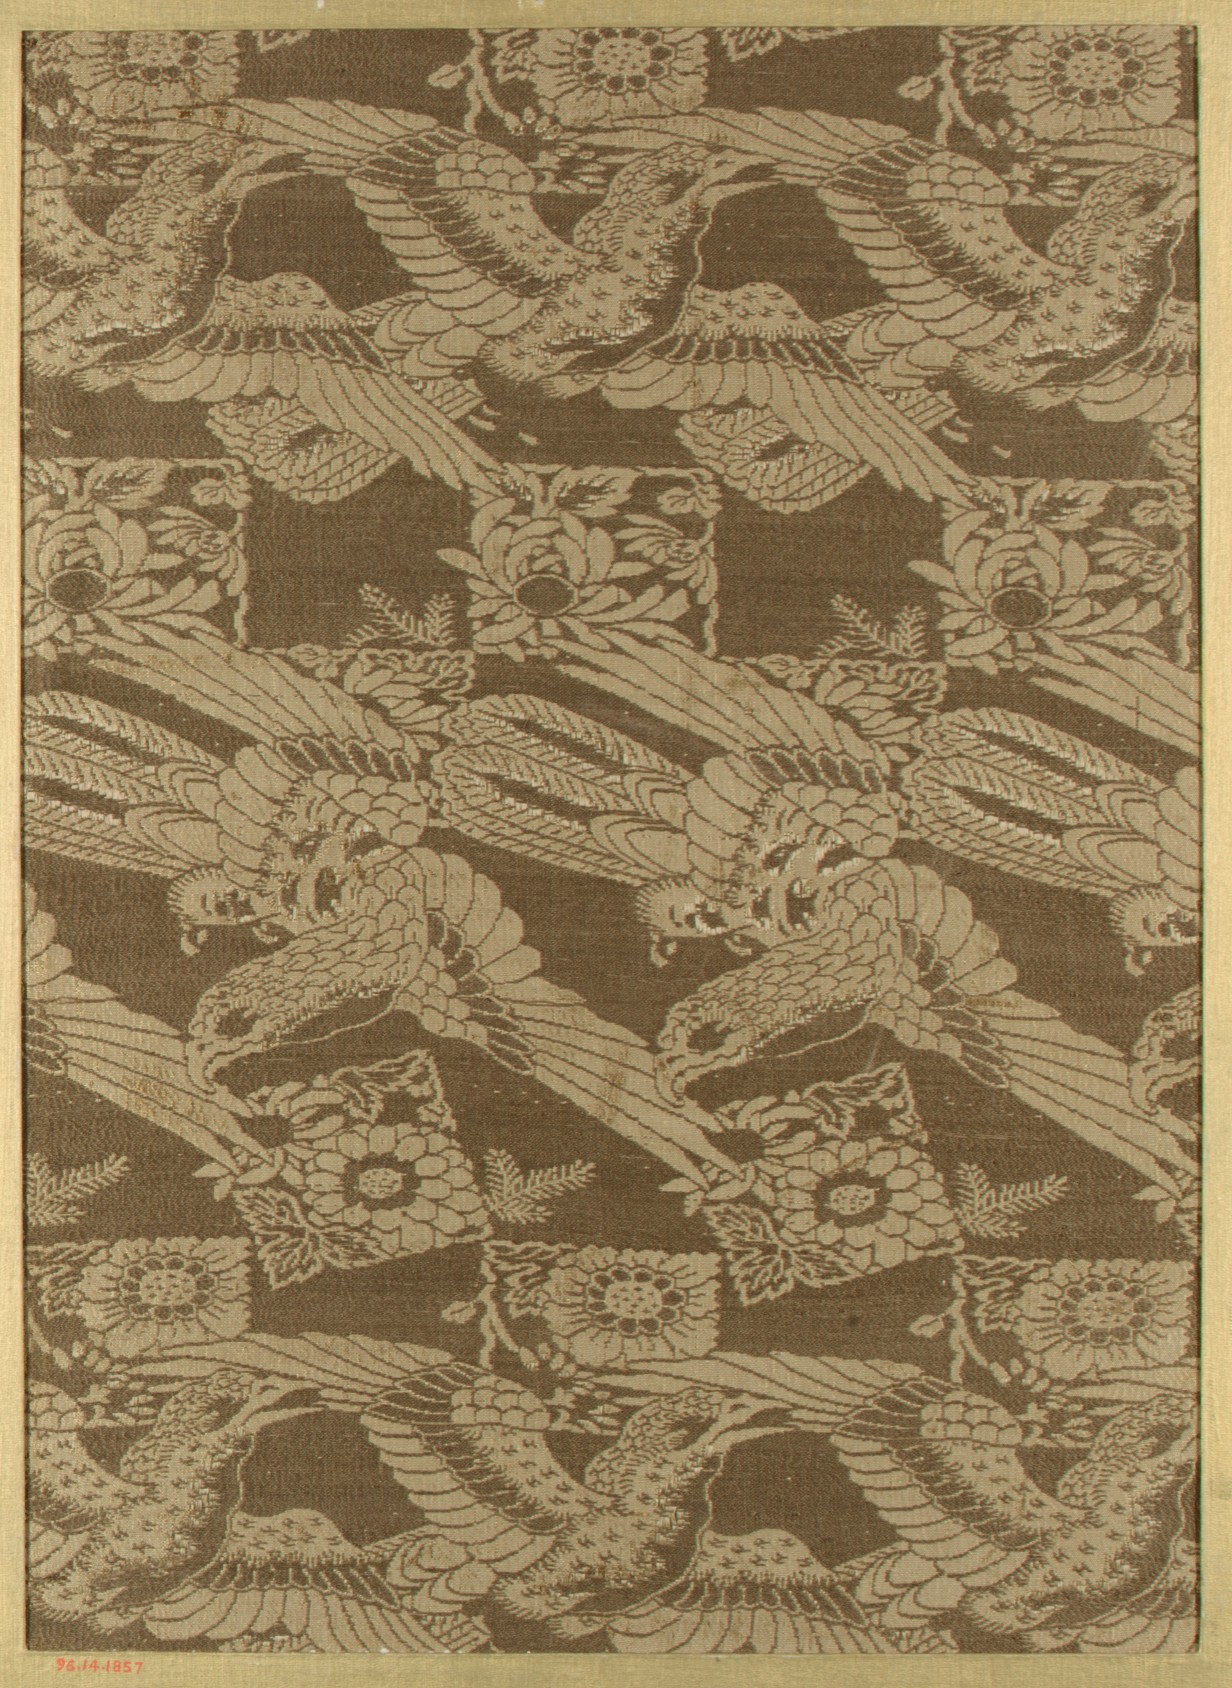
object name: piece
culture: japanese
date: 1701-1900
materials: silk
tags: hawks